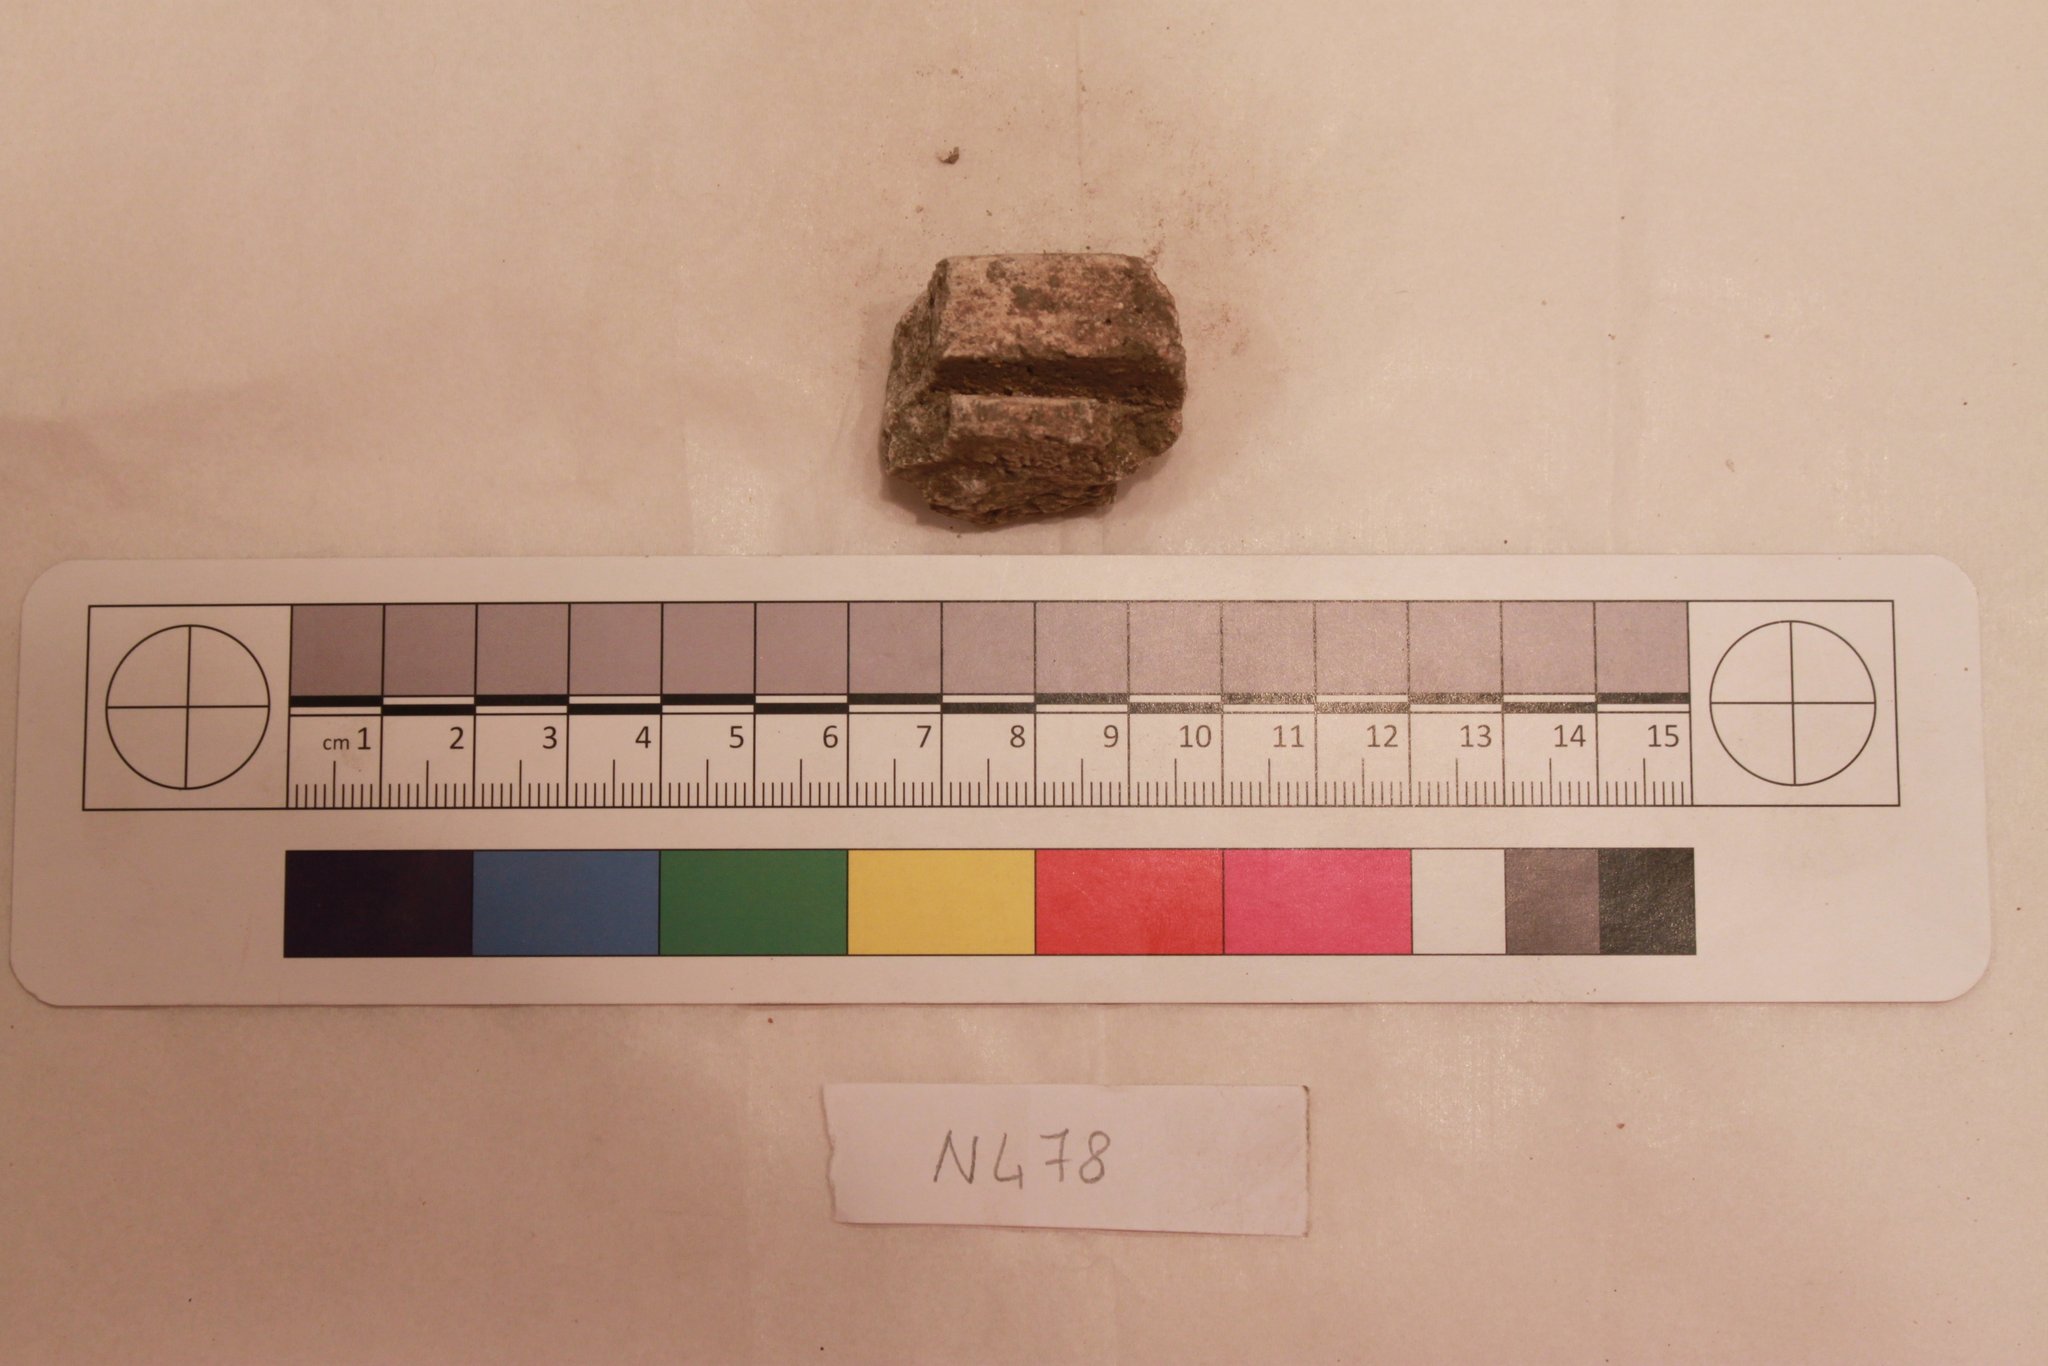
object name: fragment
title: Stucco Fragment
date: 701-1200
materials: plaster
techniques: carving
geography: iran